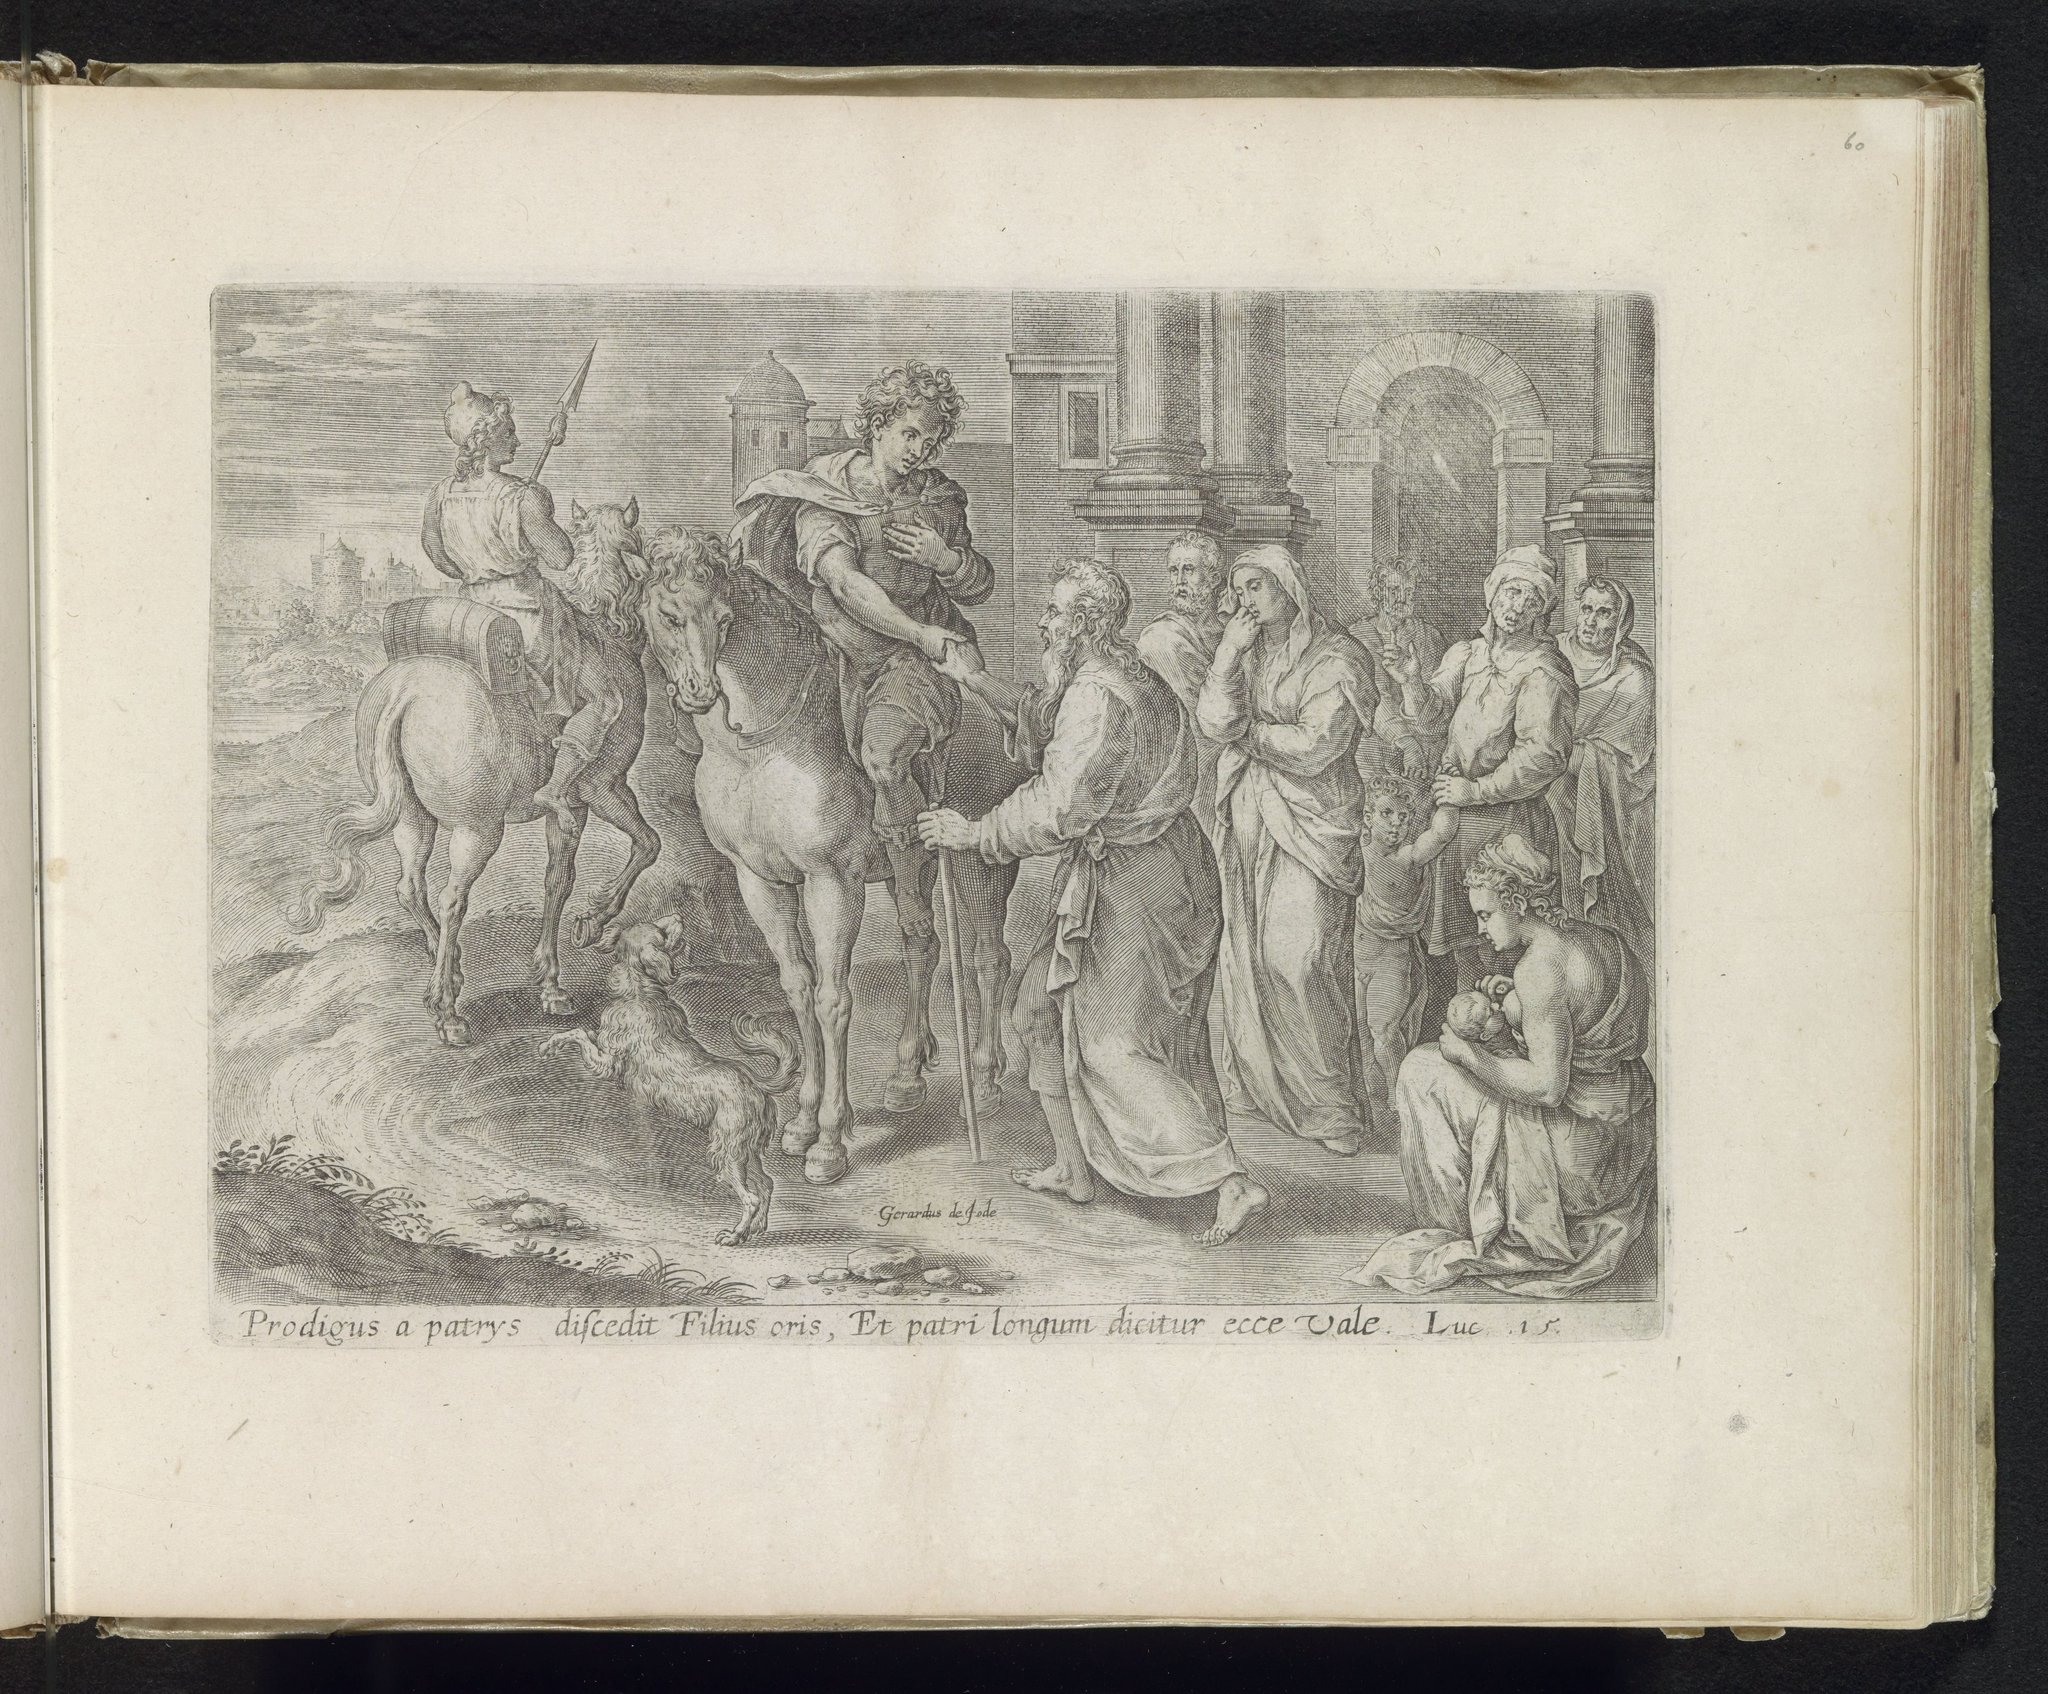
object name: album leaf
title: Gelijkenis van de verloren zoon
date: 1585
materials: paper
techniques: engraving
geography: antwerp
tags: leave-taking and departure of the prodigal son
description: De verloren zoon neemt afscheid van zijn vader. Hij zit te paard en schudt zijn vader de hand. Rechts de familie voor het huis. Onder de voorstelling een verwijzing in het Latijn naar de Bijbeltekst in Luc. 15. Deze prent maakt deel uit van een album.